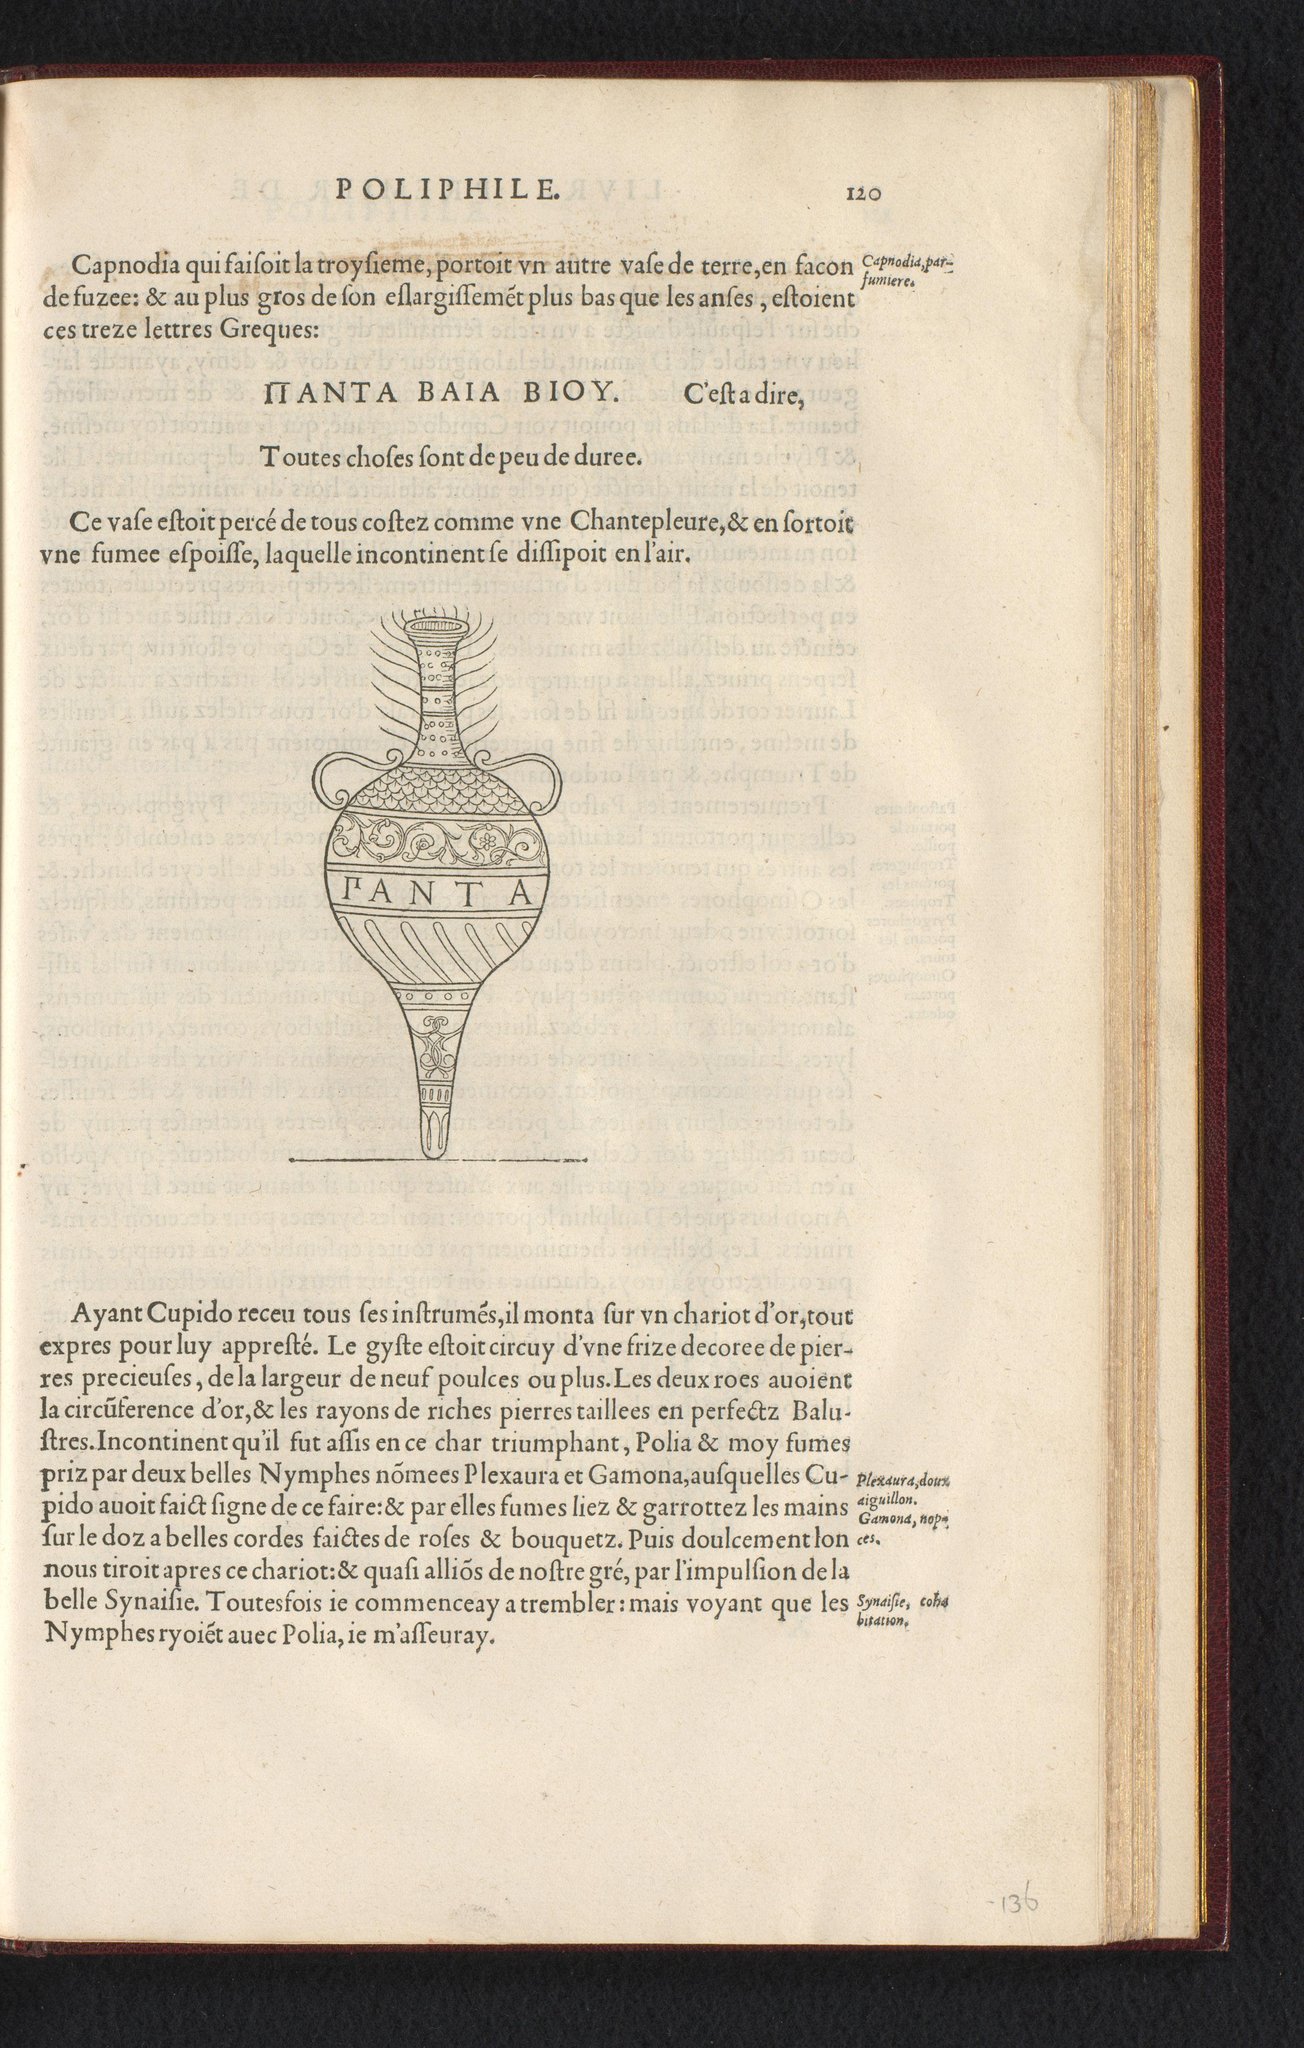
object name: print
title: Vaas met een smalle voet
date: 1546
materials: paper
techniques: letterpress printing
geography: paris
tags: vase ~ ornament, (scenes from) specific works of literature: colonna, hypnerotomachia poliphili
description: Prent uit: Colonna, Francesco. Hypnerotomachie ou discours du songe de Poliphile, deduisant comme amour le combat a l'occasion de Polia. Parijs: Jacques Kerver, 1546, recto fol. 120.